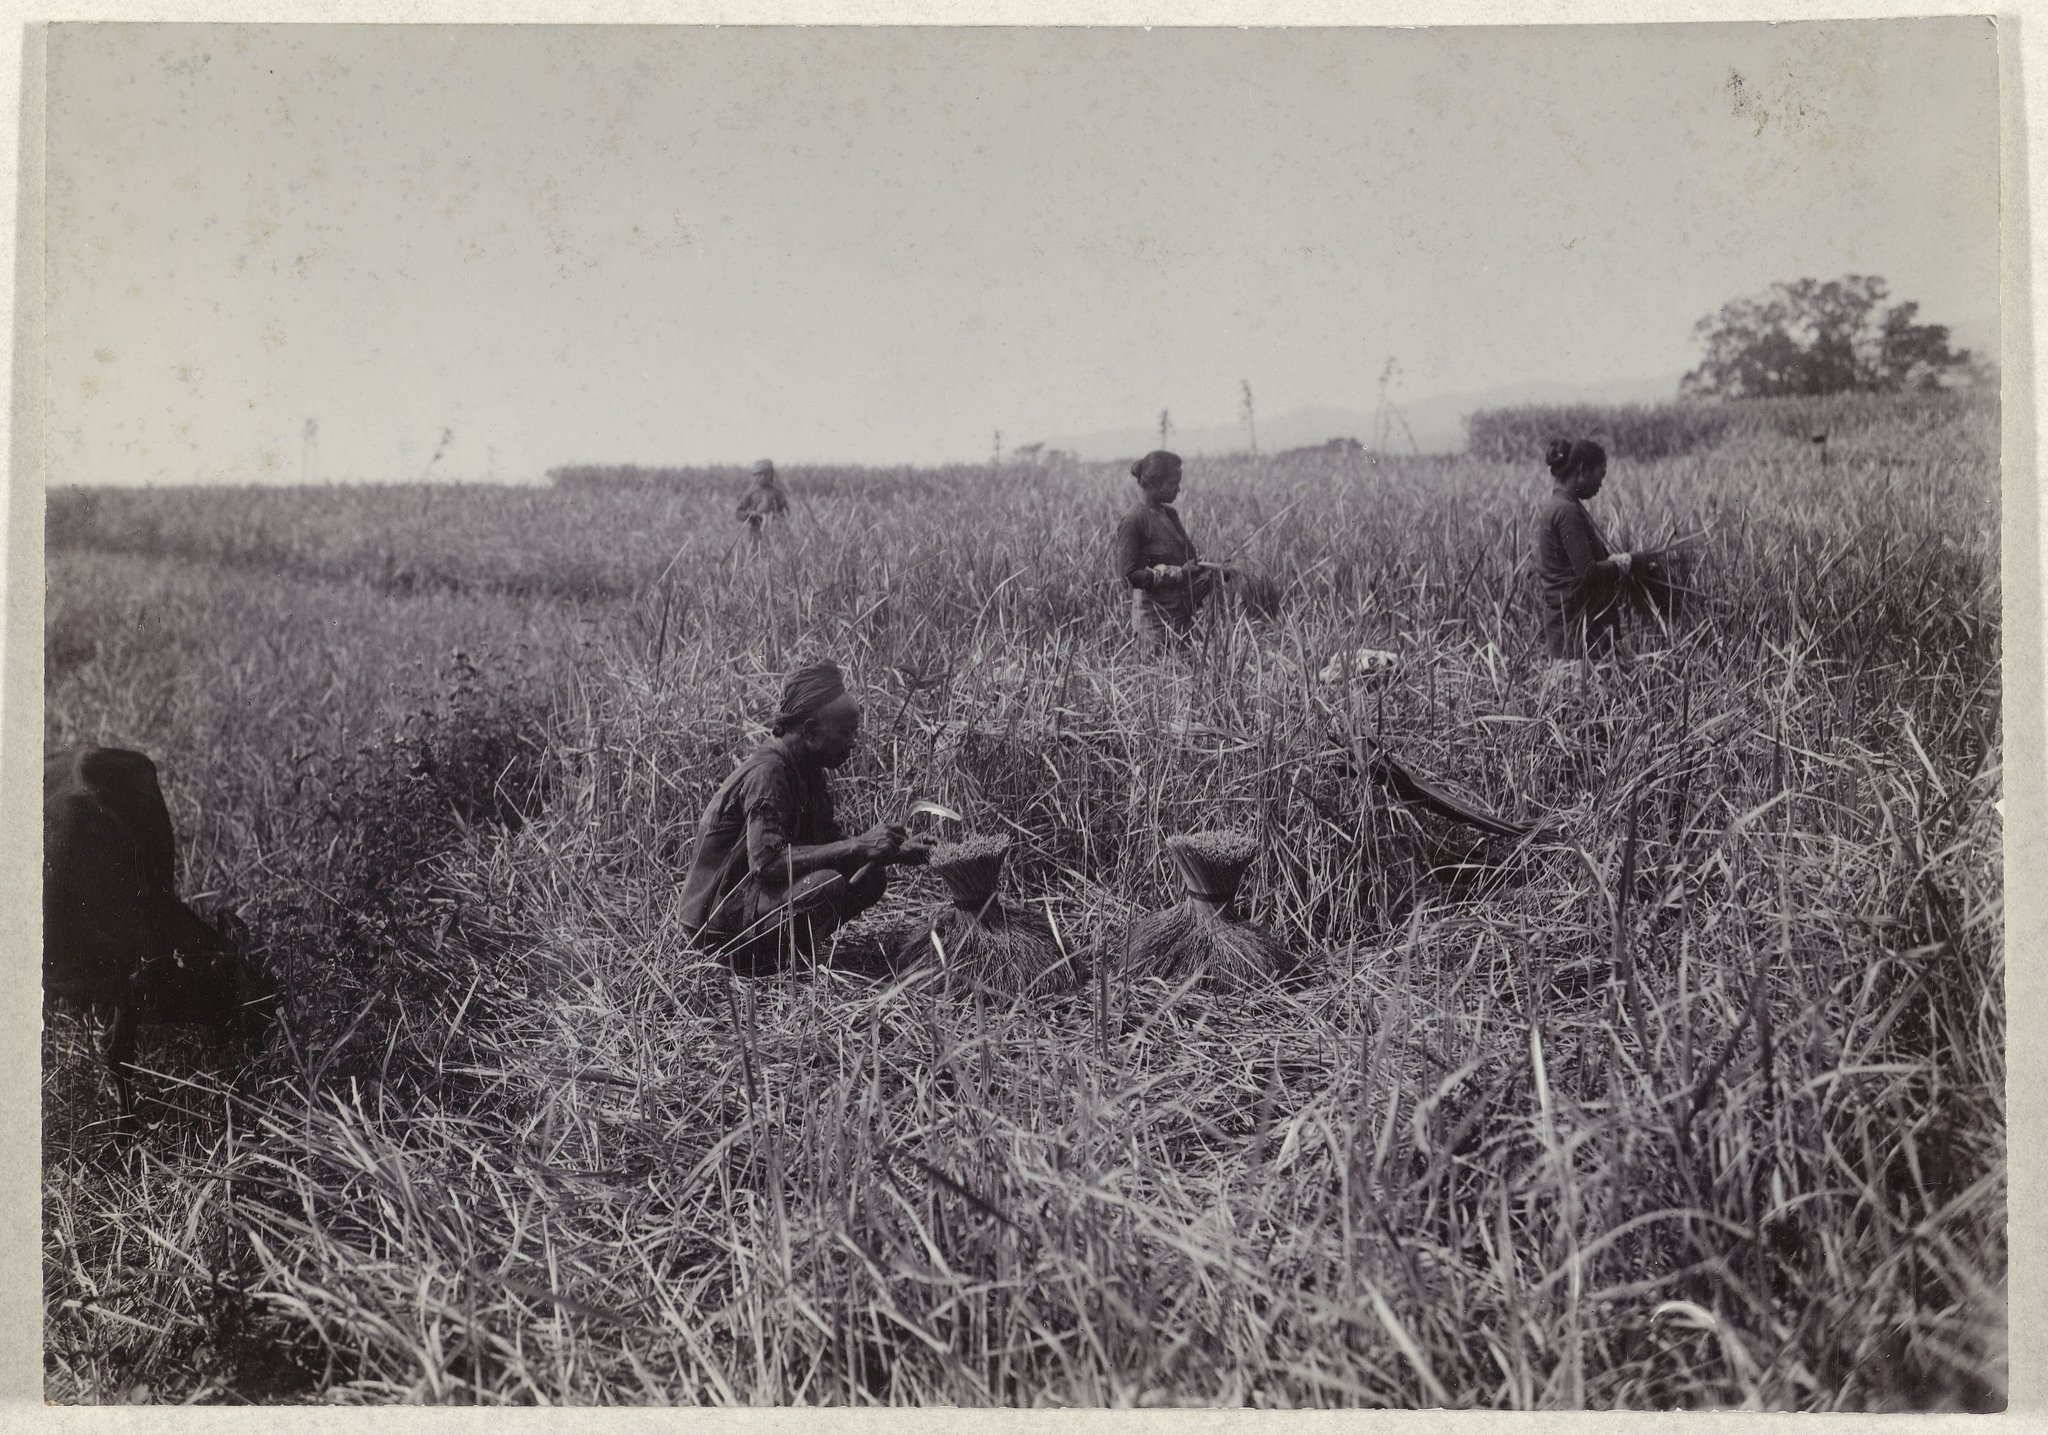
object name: photograph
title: Plateau-paddiveld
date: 1913-1923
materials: paper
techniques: gelatin silver print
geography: java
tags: harvest, sawahs, rice paddies, java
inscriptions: inscription: ‘Serie P./ No 223/ f 0,50’, inscription: ‘N.V. photografisch atelier/ O. Kurkdjian/ Soerabaia, Java.’